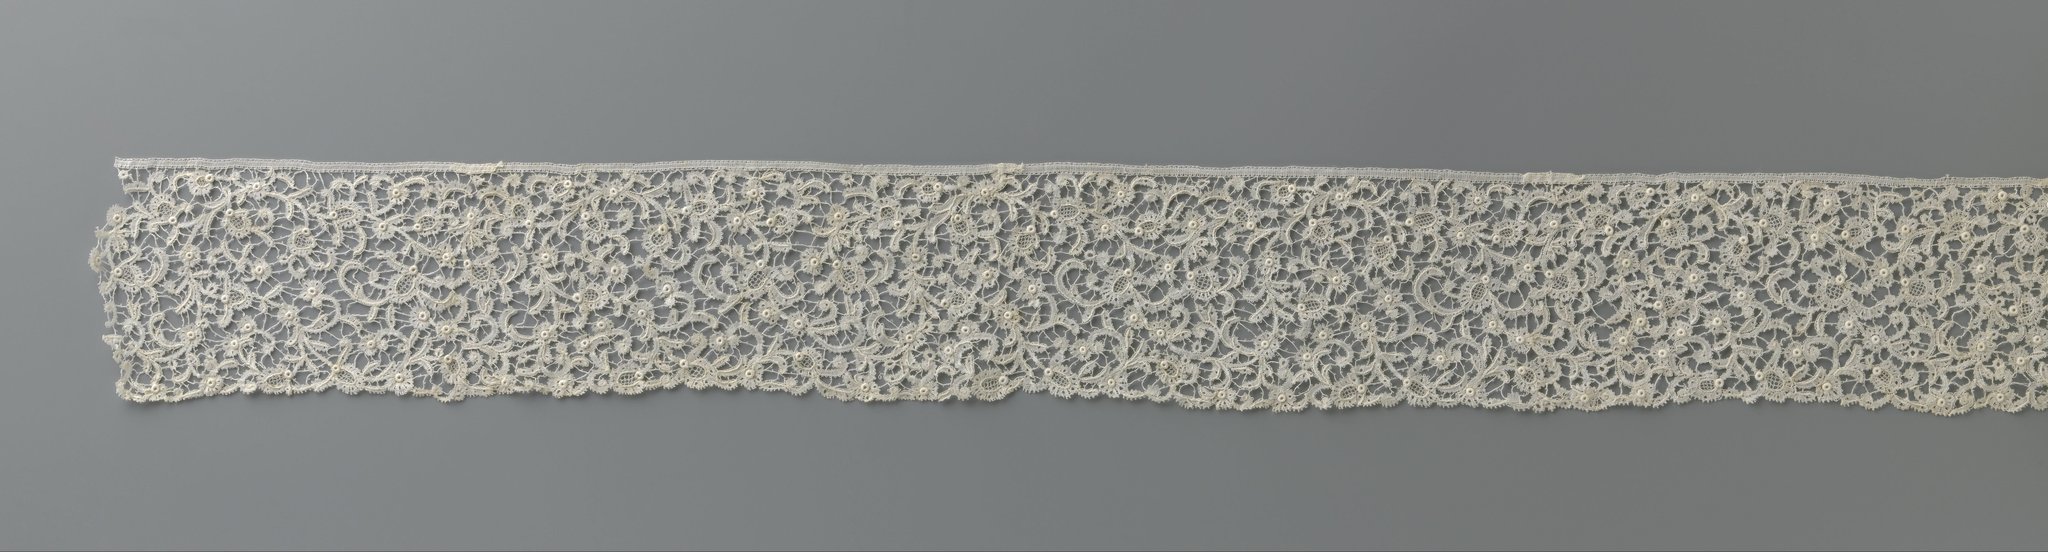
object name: strip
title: Strook gemengde kant met gekloste bloemen en 'pareltjes' als bloemharten gemaakt met gefestonneerde naaldkantringetjes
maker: Anonymous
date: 1900-1949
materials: linen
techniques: lace, rosaline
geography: belgium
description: Strook naturelkleurige gemengde kant: geparelde rosaline. Het zich herhalende patroon bestaat uit vele omkrullende rankjes met verschillende soorten kleine en iets grotere bloempjes. De motieven zijn geklost in linnenslag met uitsparingen een deels voorzien van gekloste reliëfcontouren. De bloemharten zijn voorzien van 'pareltjes': gefestonneerde naaldkantringetjes. In de bloemharten van de grotere bloempjes is een gekloste siergrond toegepast, een gesloten speldslag-grond. De bovenzijde is recht afgewerkt met een recht geklost bandje. De vrijwel rechte onderzijde waarbij de motiefjes minimale schulpjes vormen is afgewerkt met picots.